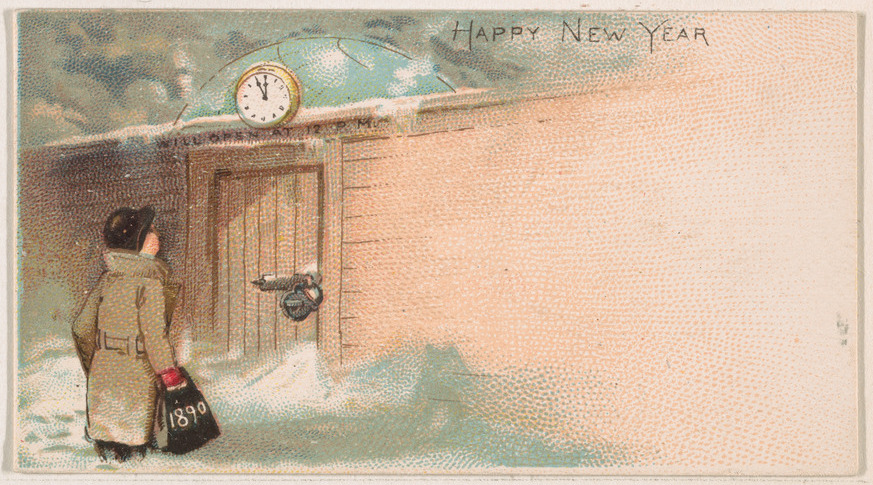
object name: print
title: Happy New Year, from the New Years 1890 series (N227) issued by Kinney Bros.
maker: kinney brothers tobacco company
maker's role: publisher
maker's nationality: american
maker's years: 1869-2011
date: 1889-1890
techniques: color lithograph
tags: human figures,doors,clocks